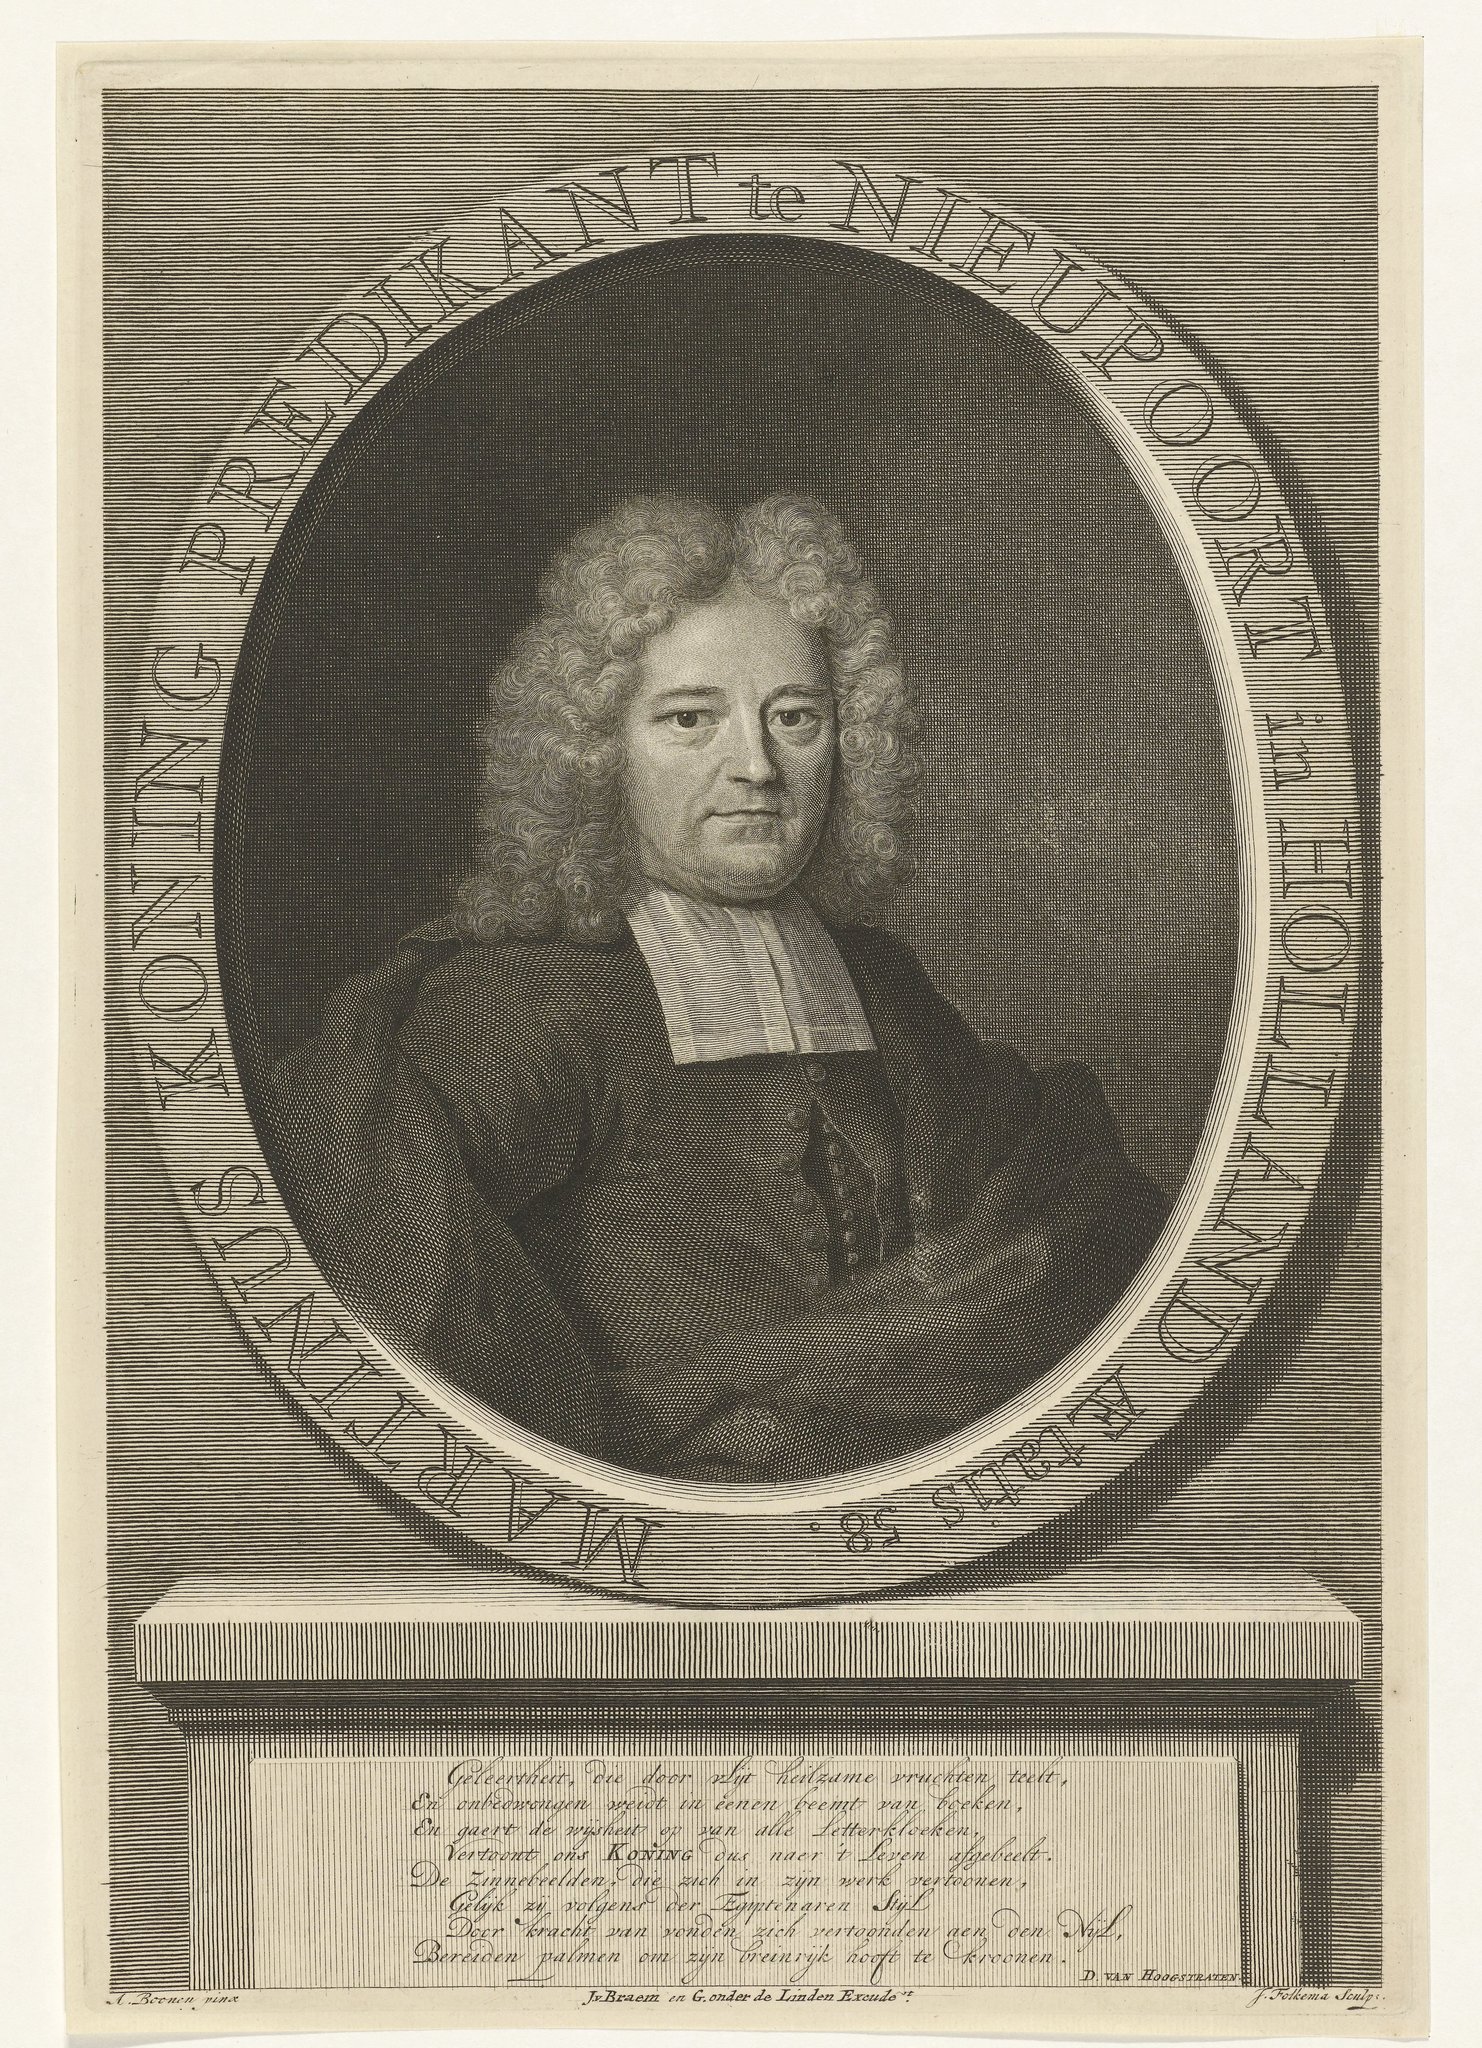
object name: print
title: Portret van Martinus Koning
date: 1720-1767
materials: paper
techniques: engraving, etching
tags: predikant, martinus koning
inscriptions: collector's mark: Lugt 240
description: Portretbuste in ovaal naar rechts van predikant Martinus Koning, blootshoofds en gehuld in een toga. Rond het ovaal staat een randschrift, op de sokkel onder het portret een achtregelige tekst in het Nederlands.